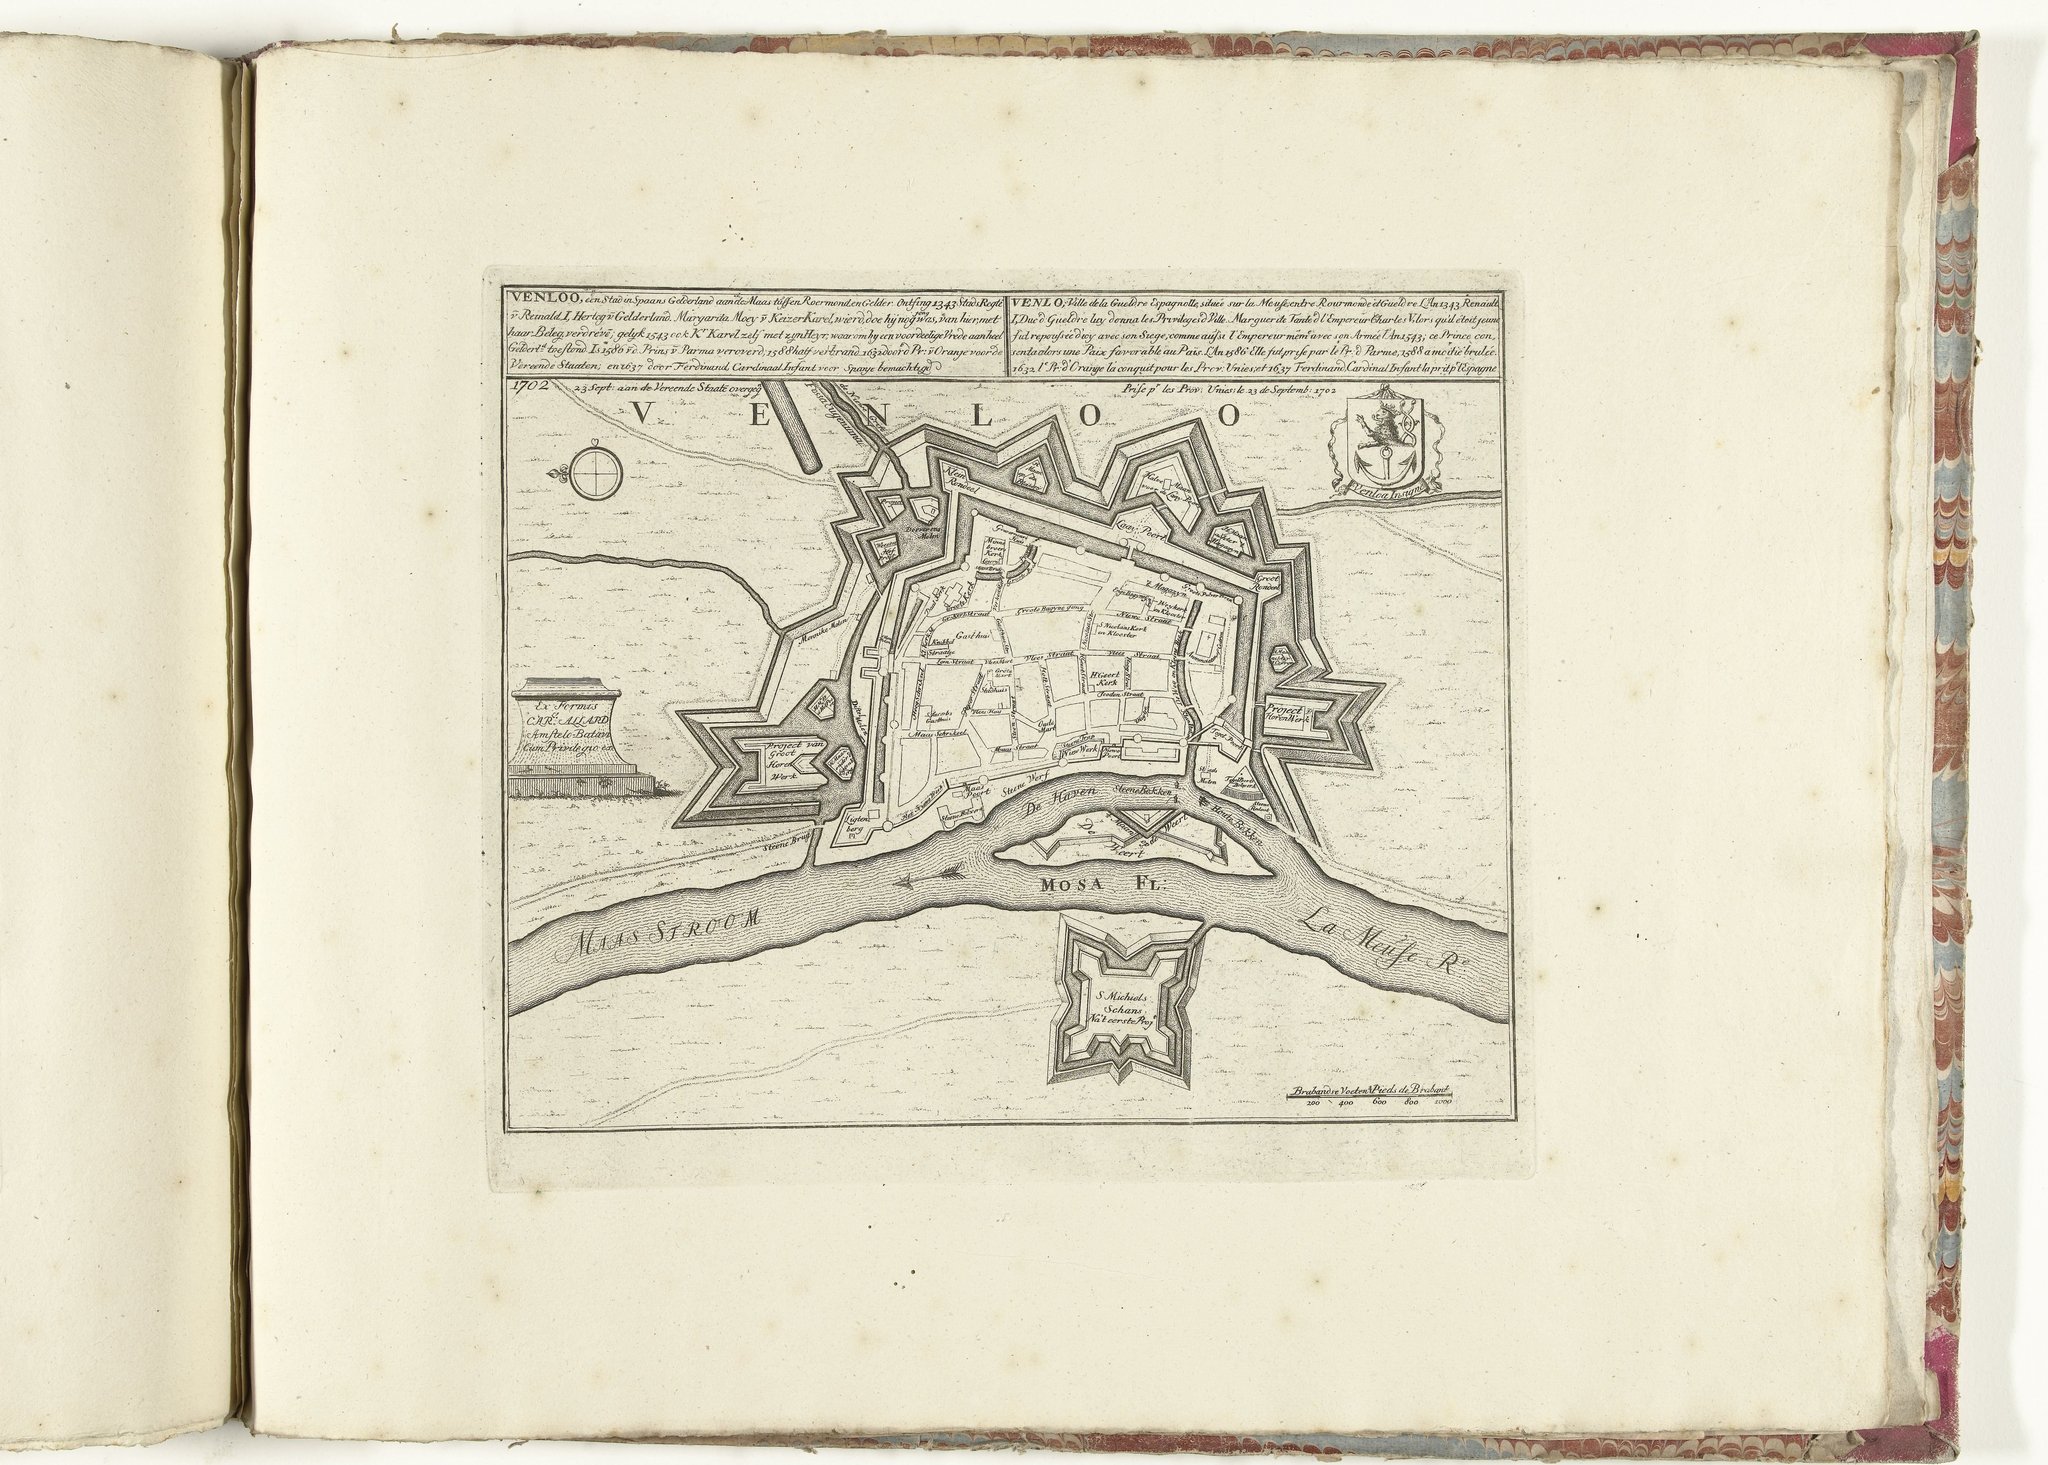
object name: print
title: Les Principales Forteresses & Villes Fortes, d'Espagne, de France, d'Italie, de Savoië, d'Allemagne & des Païs-Bas (...) / Naaukeurige Afbeeldingen der Voornaamste Sterke Steden en Vestingen in Spanjen, Vrankryk, Italien, Savoyen, Duytsland en Nederlanden (...)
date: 1702-1714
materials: paper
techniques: etching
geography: leiden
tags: maps of cities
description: Gekopieerd naar de Franse prenten in: Nicolas de Fer, Les forces de l'Europe, ou description des principales villes, avec leurs fortifications : dessignées par les meilleurs ingenieurs, particulierement celles ... de la France, dont les plans ont esté levez par M. de Vauban, Nicolas de Fer, Parijs 1693-1696, of andere voorbeelden.